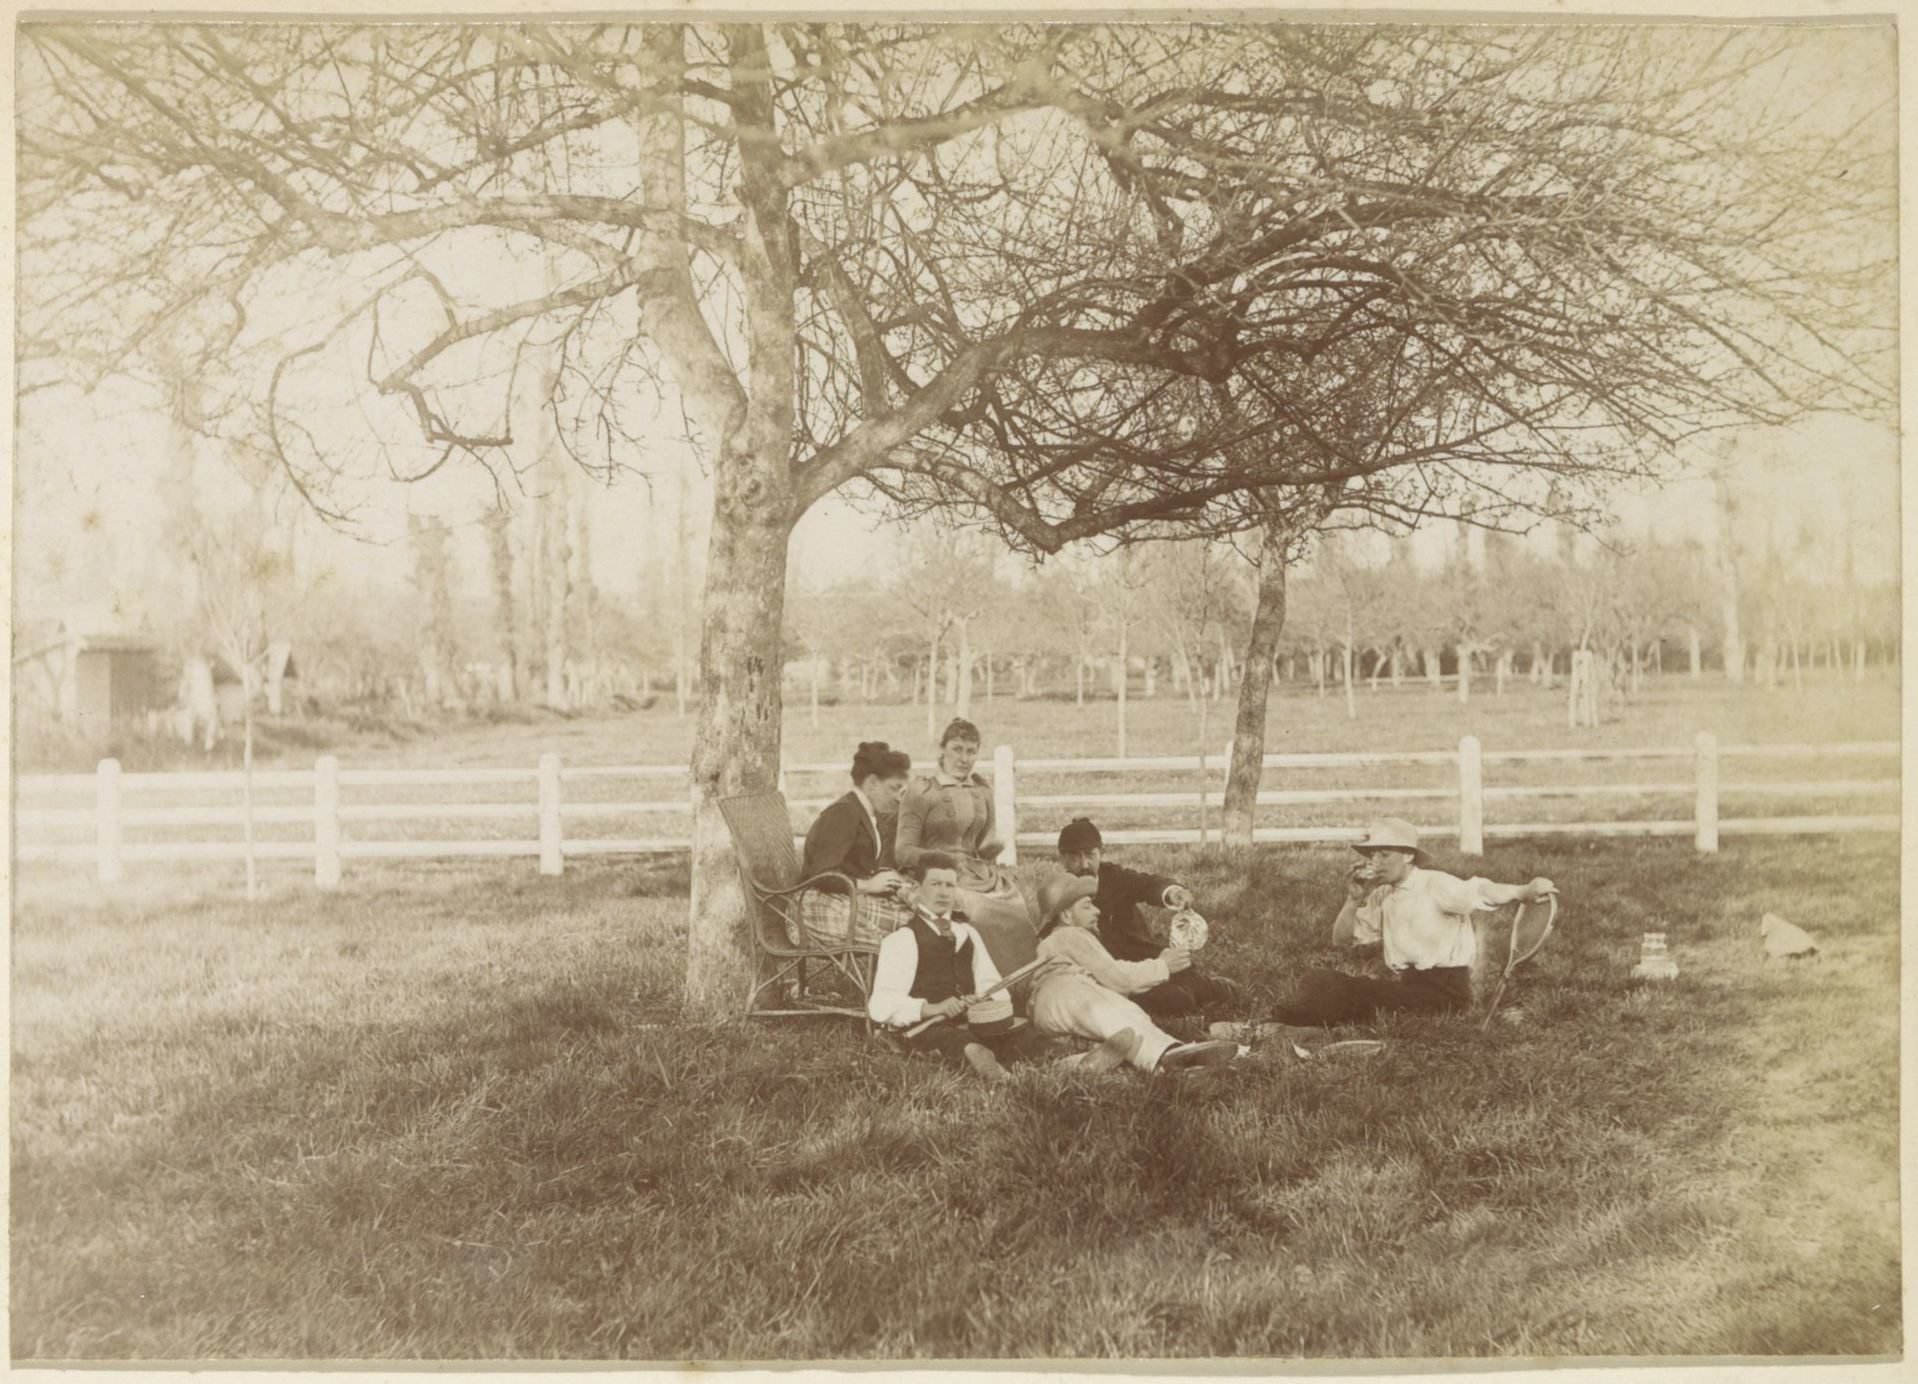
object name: photograph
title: Gezelschap rust uit in de schaduw van een boom na een tennispartij in Frankrijk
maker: Anonymous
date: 1900-1910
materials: paper, photographic support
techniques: albumen print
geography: france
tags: tennis, lawn-tennis, eating and drinking, resting, france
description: Onderdeel van Fotoalbum van een Franse amateurfotograaf met opnames van een familie, distilleerderij Delizy & Doistau Fils, het leger en bezienswaardigheden in Frankrijk.